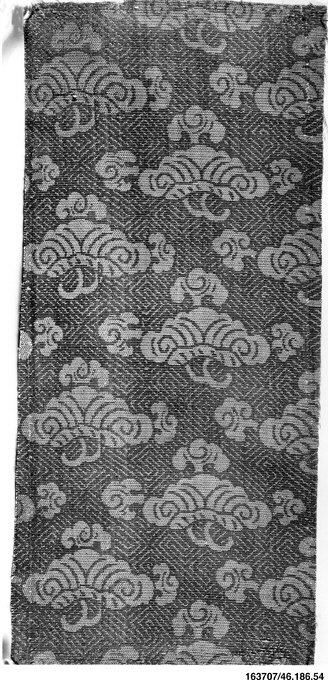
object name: sutra cover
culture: chinese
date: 1601-1700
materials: silk